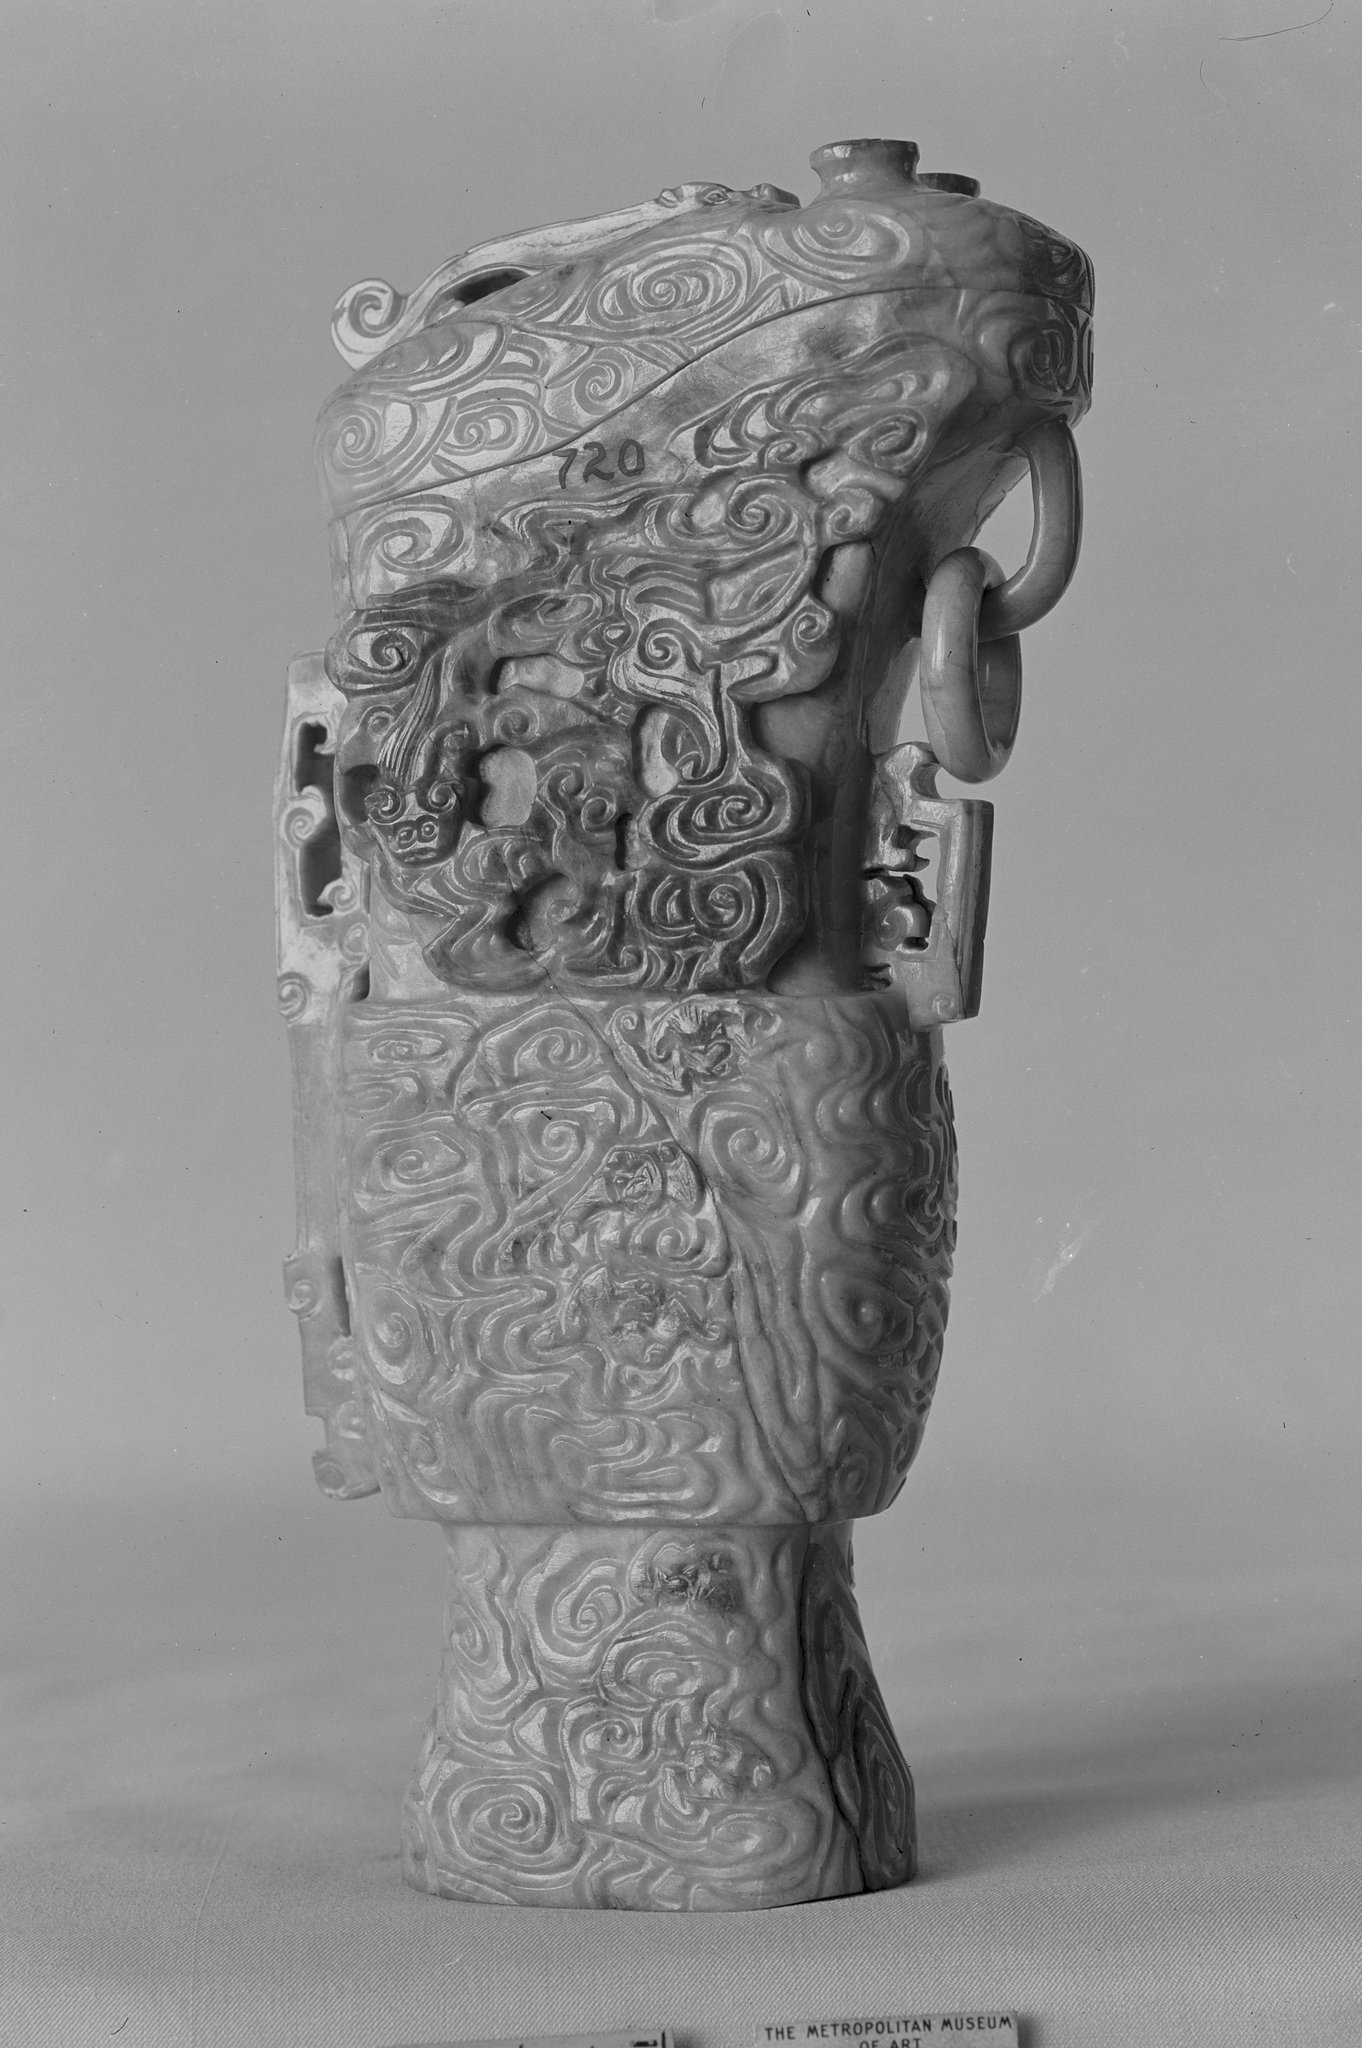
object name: vessel with cover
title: Sacrificial Vessel with Cover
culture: chinese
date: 1796-1875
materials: gemstone, jade